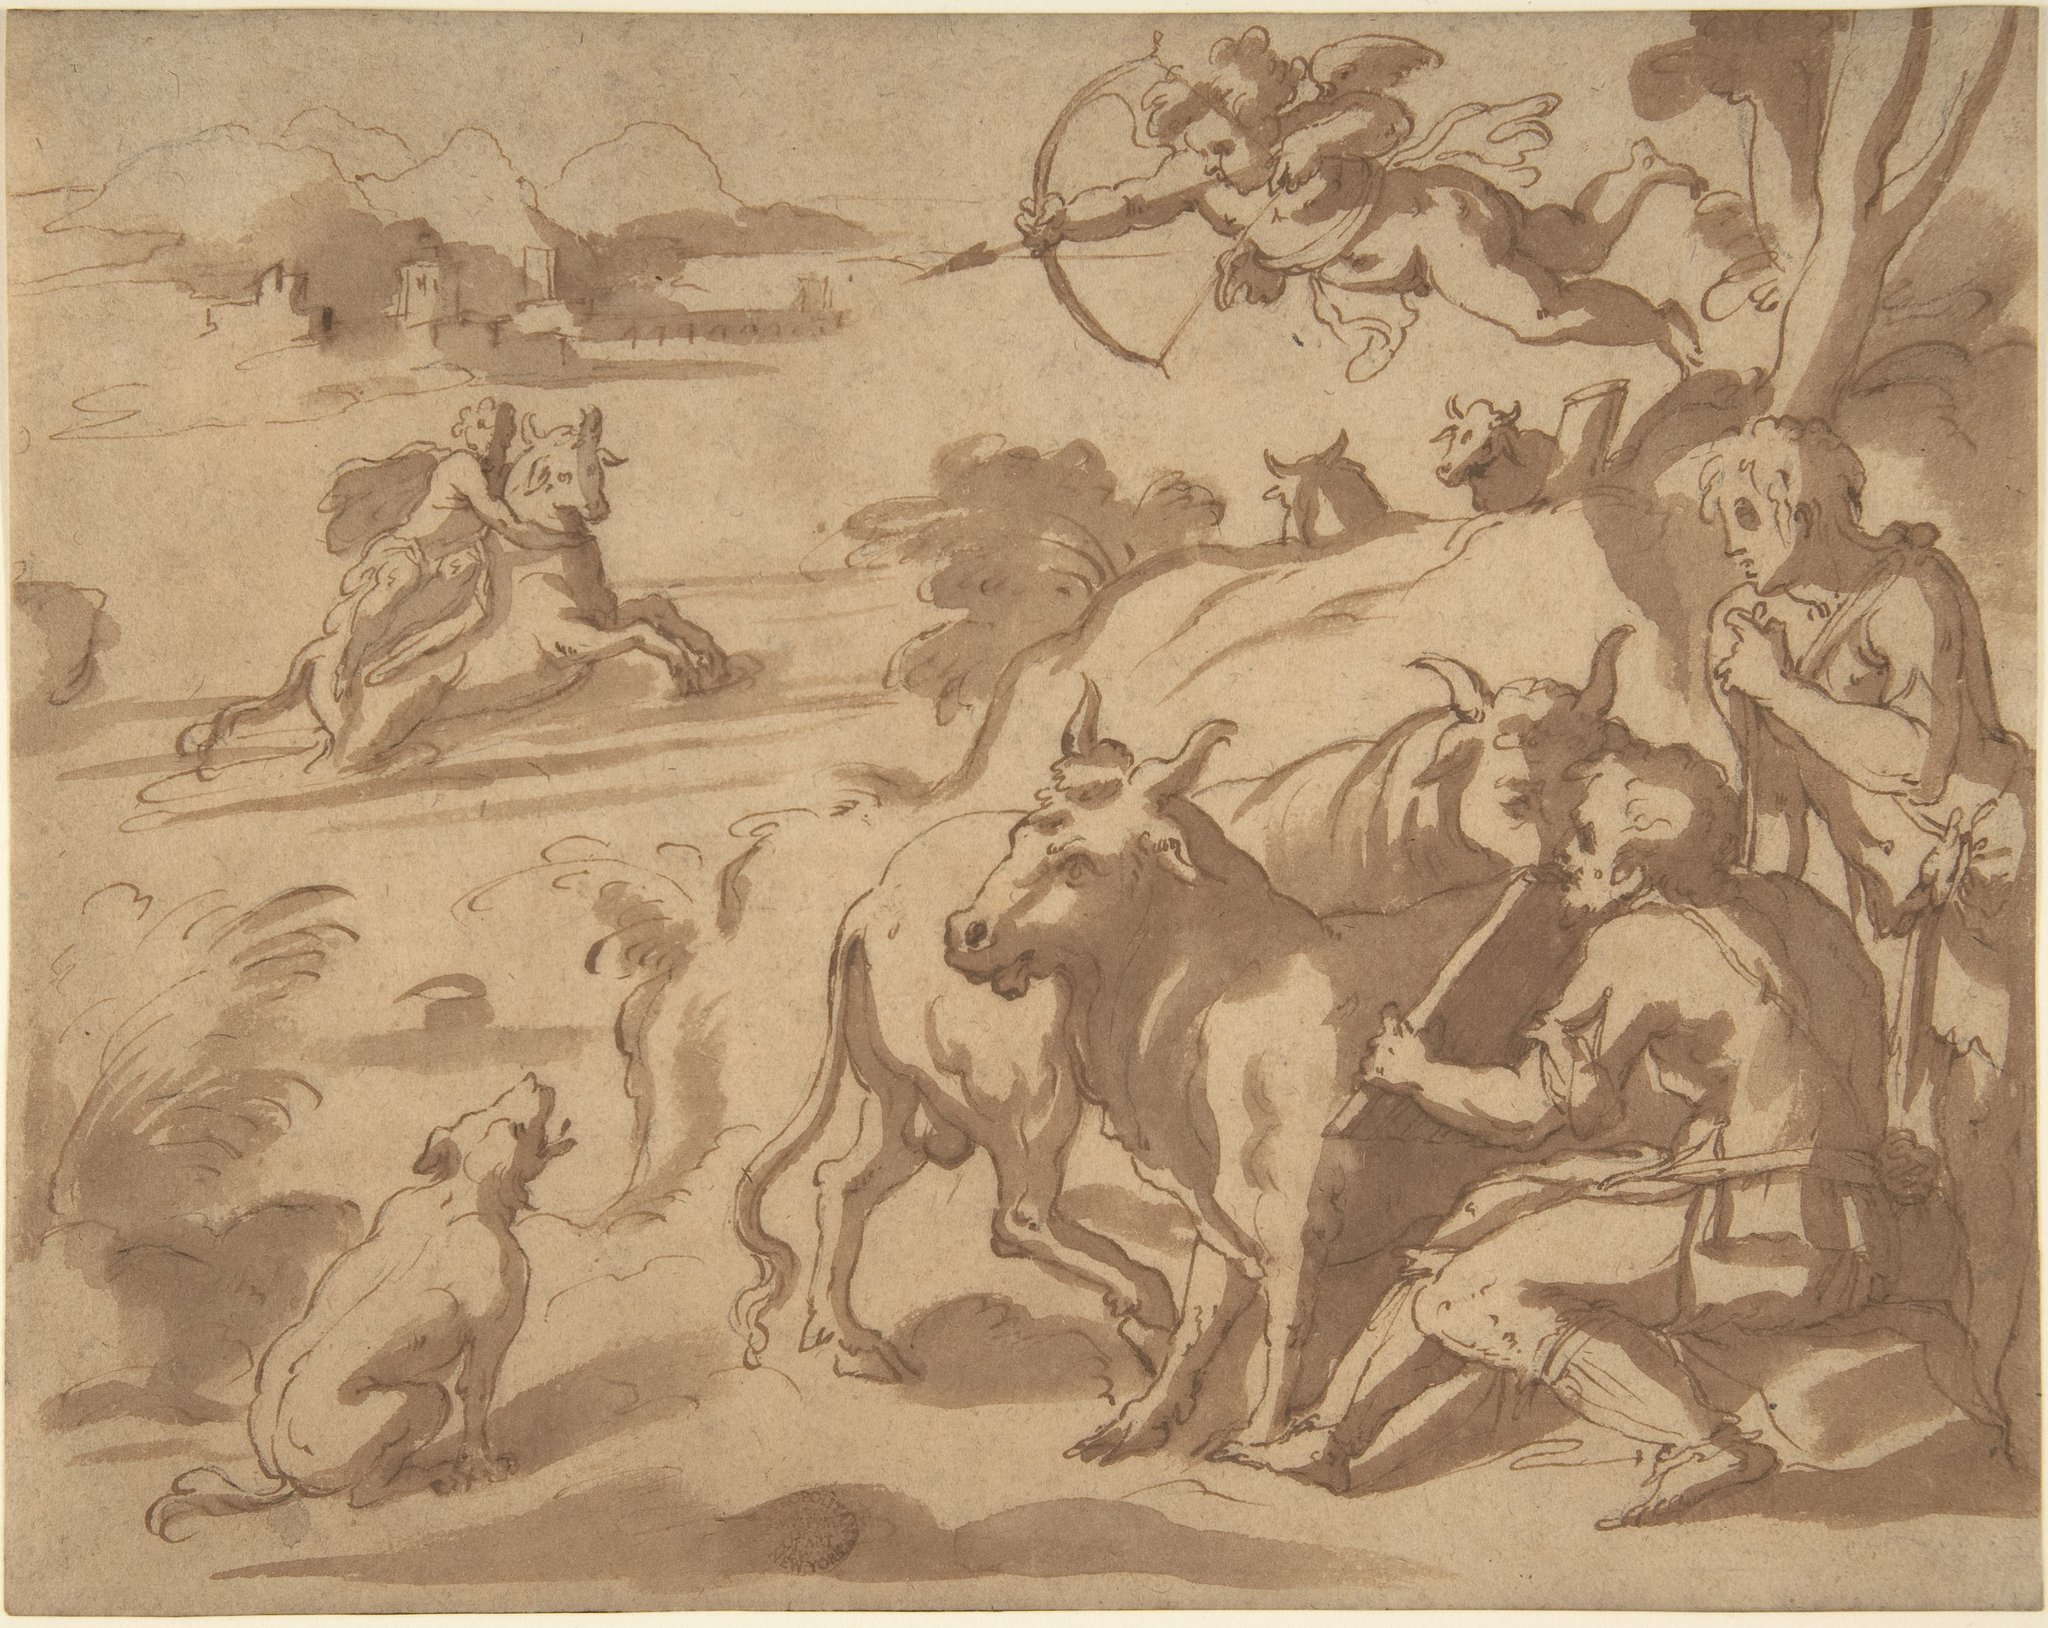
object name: drawing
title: Europa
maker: anonymous, italian, 16th century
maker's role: artist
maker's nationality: italian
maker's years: 1550-1600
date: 1501-1600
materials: ink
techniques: brush, pen, wash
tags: cupid,europa,cows,dogs,horses